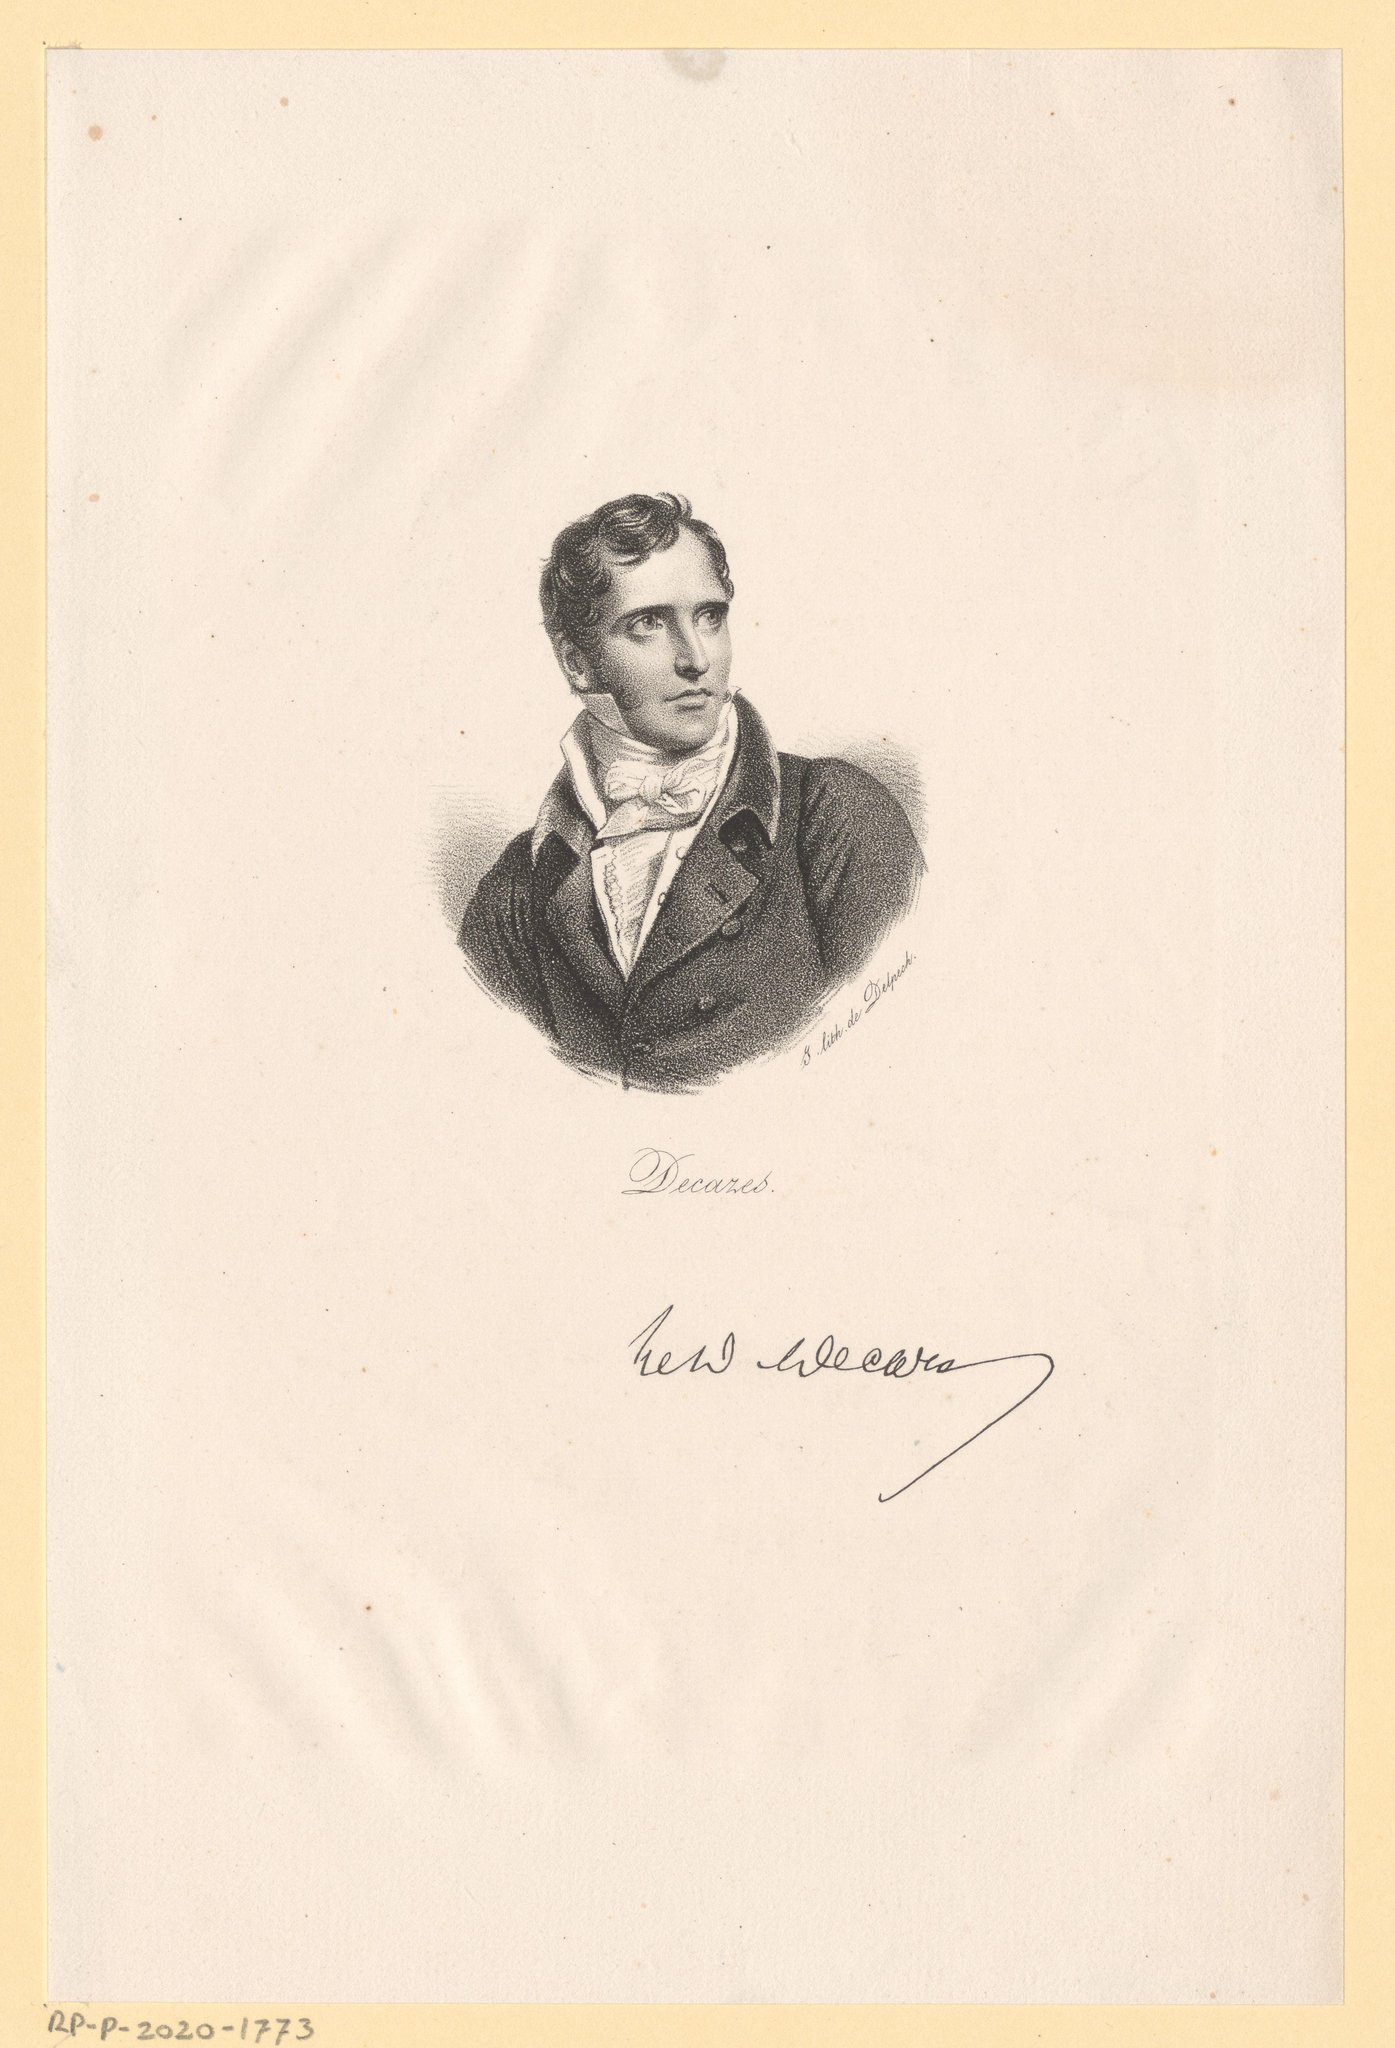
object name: print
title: Portret van Élie Decazes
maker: Anonymous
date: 1818-1842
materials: paper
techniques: lithograph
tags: france, earl, official; civil servant; functionary (in general), historical persons